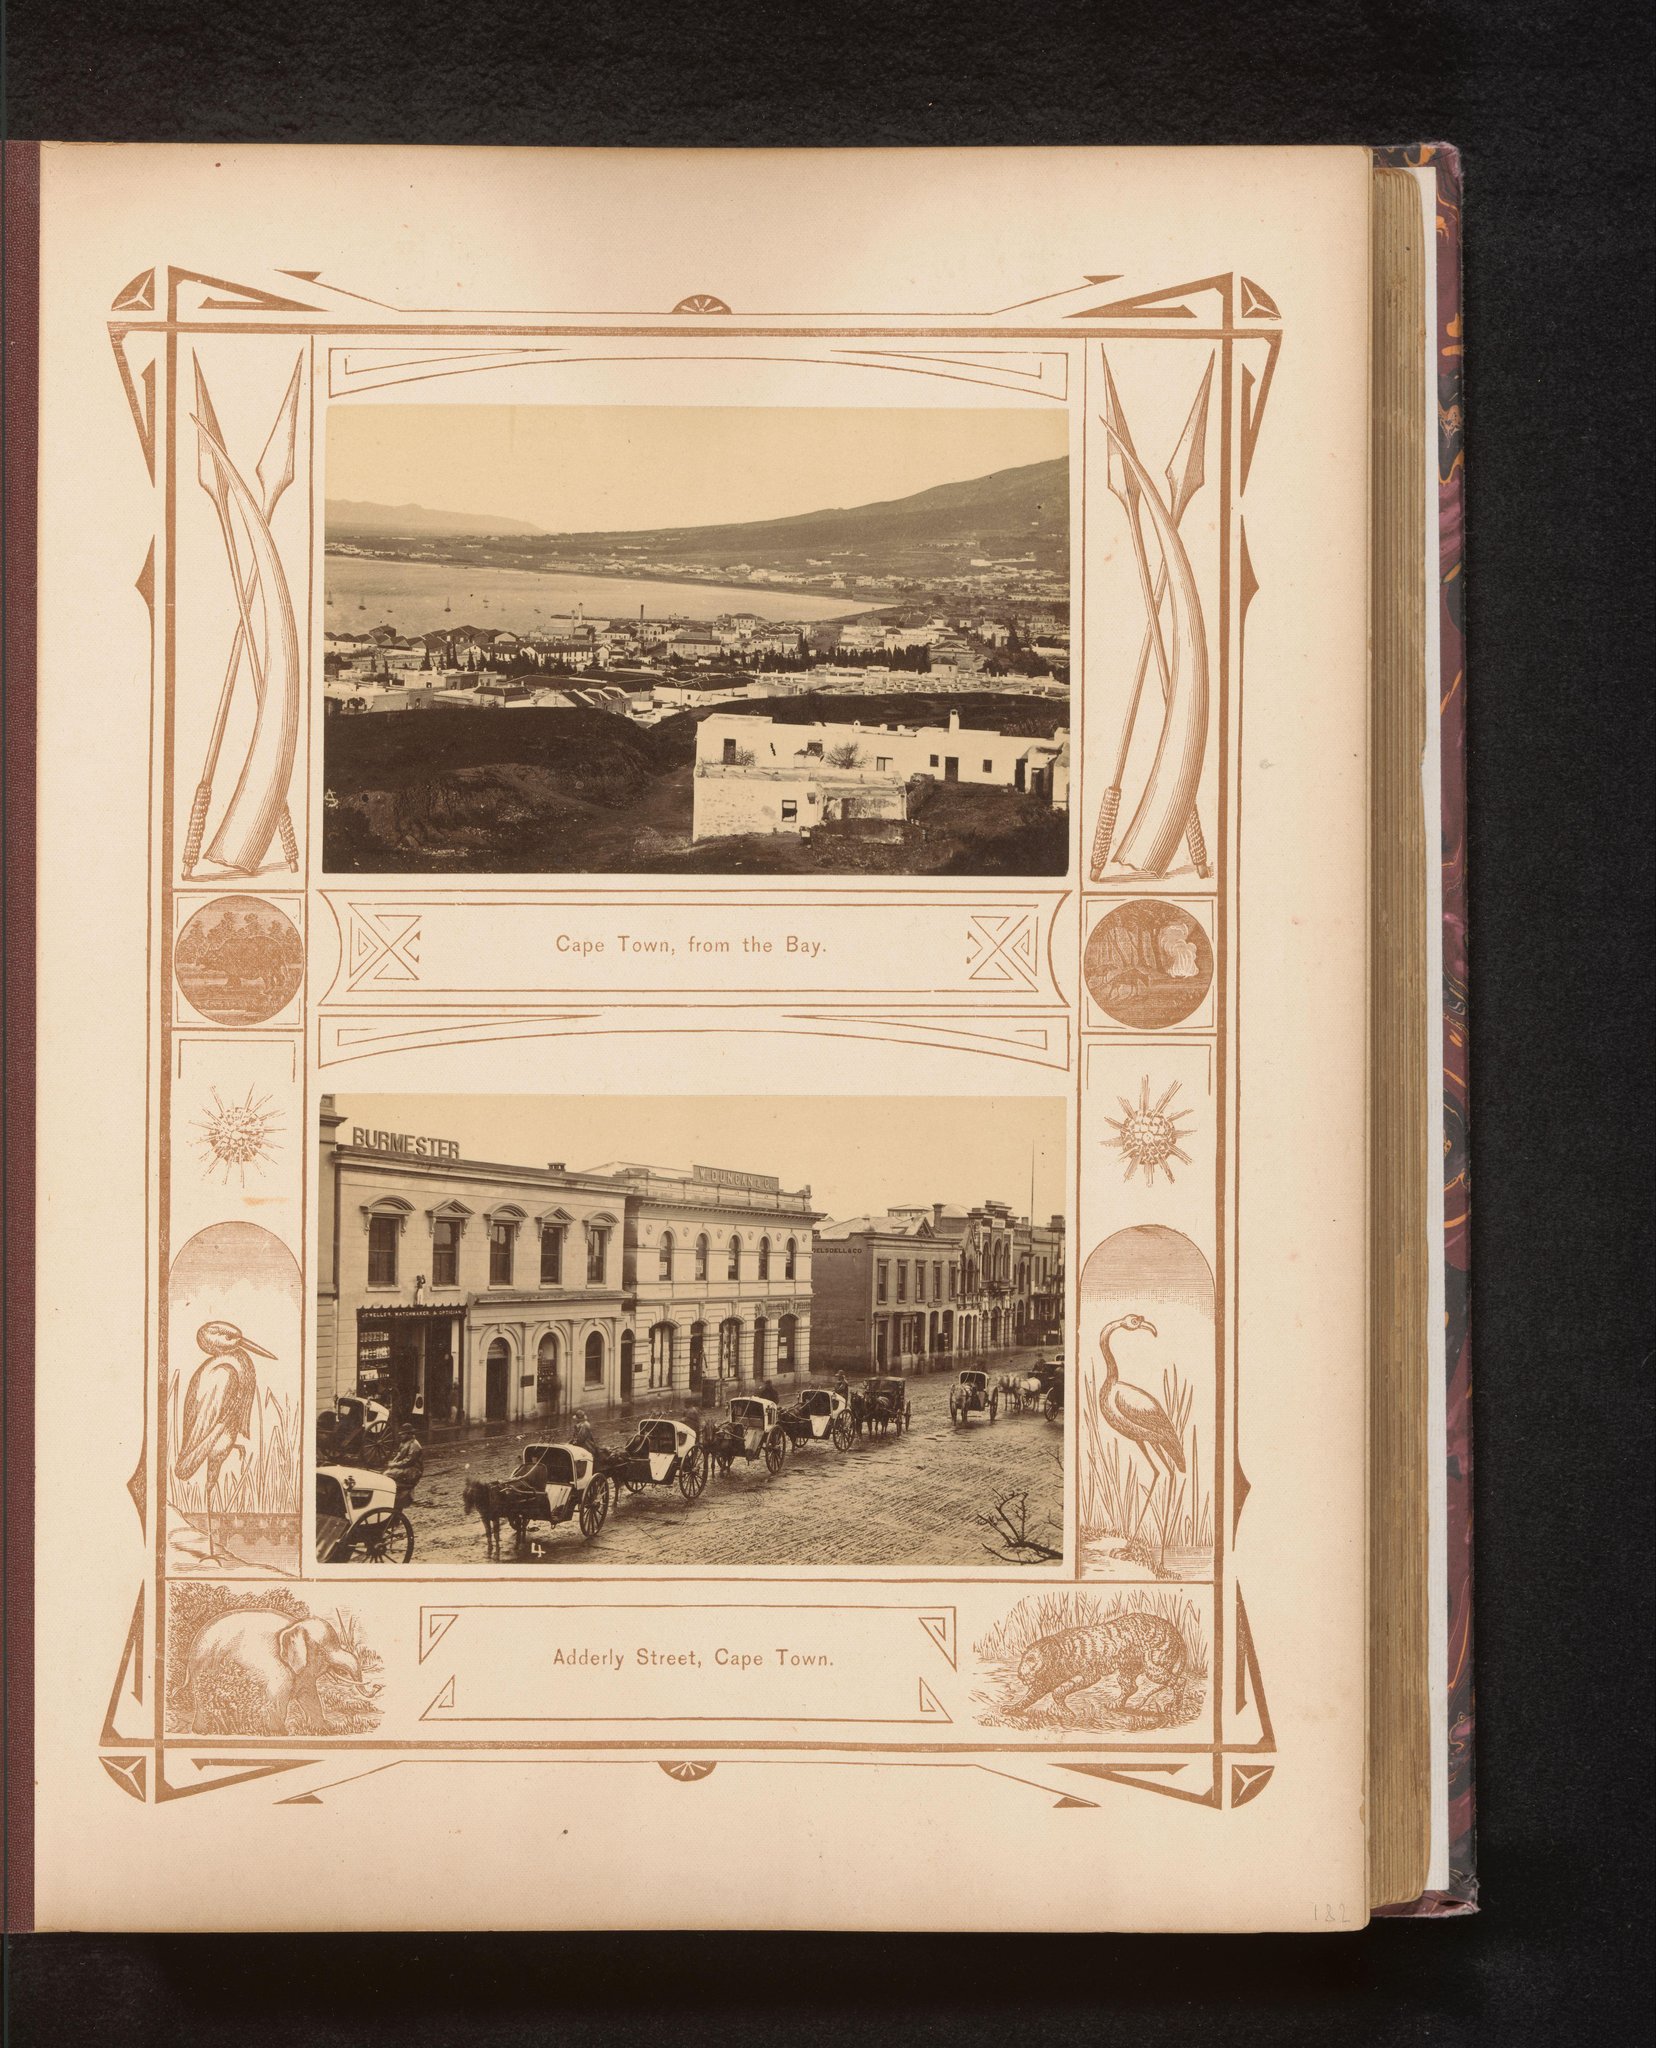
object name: photograph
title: Gezicht op Kaapstad vanaf de baai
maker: Anonymous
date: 1877-1882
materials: photographic support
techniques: albumen print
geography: cape town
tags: city-view in general; 'veduta', landscapes with waters, waterscapes, seascapes (in the temperate zone)